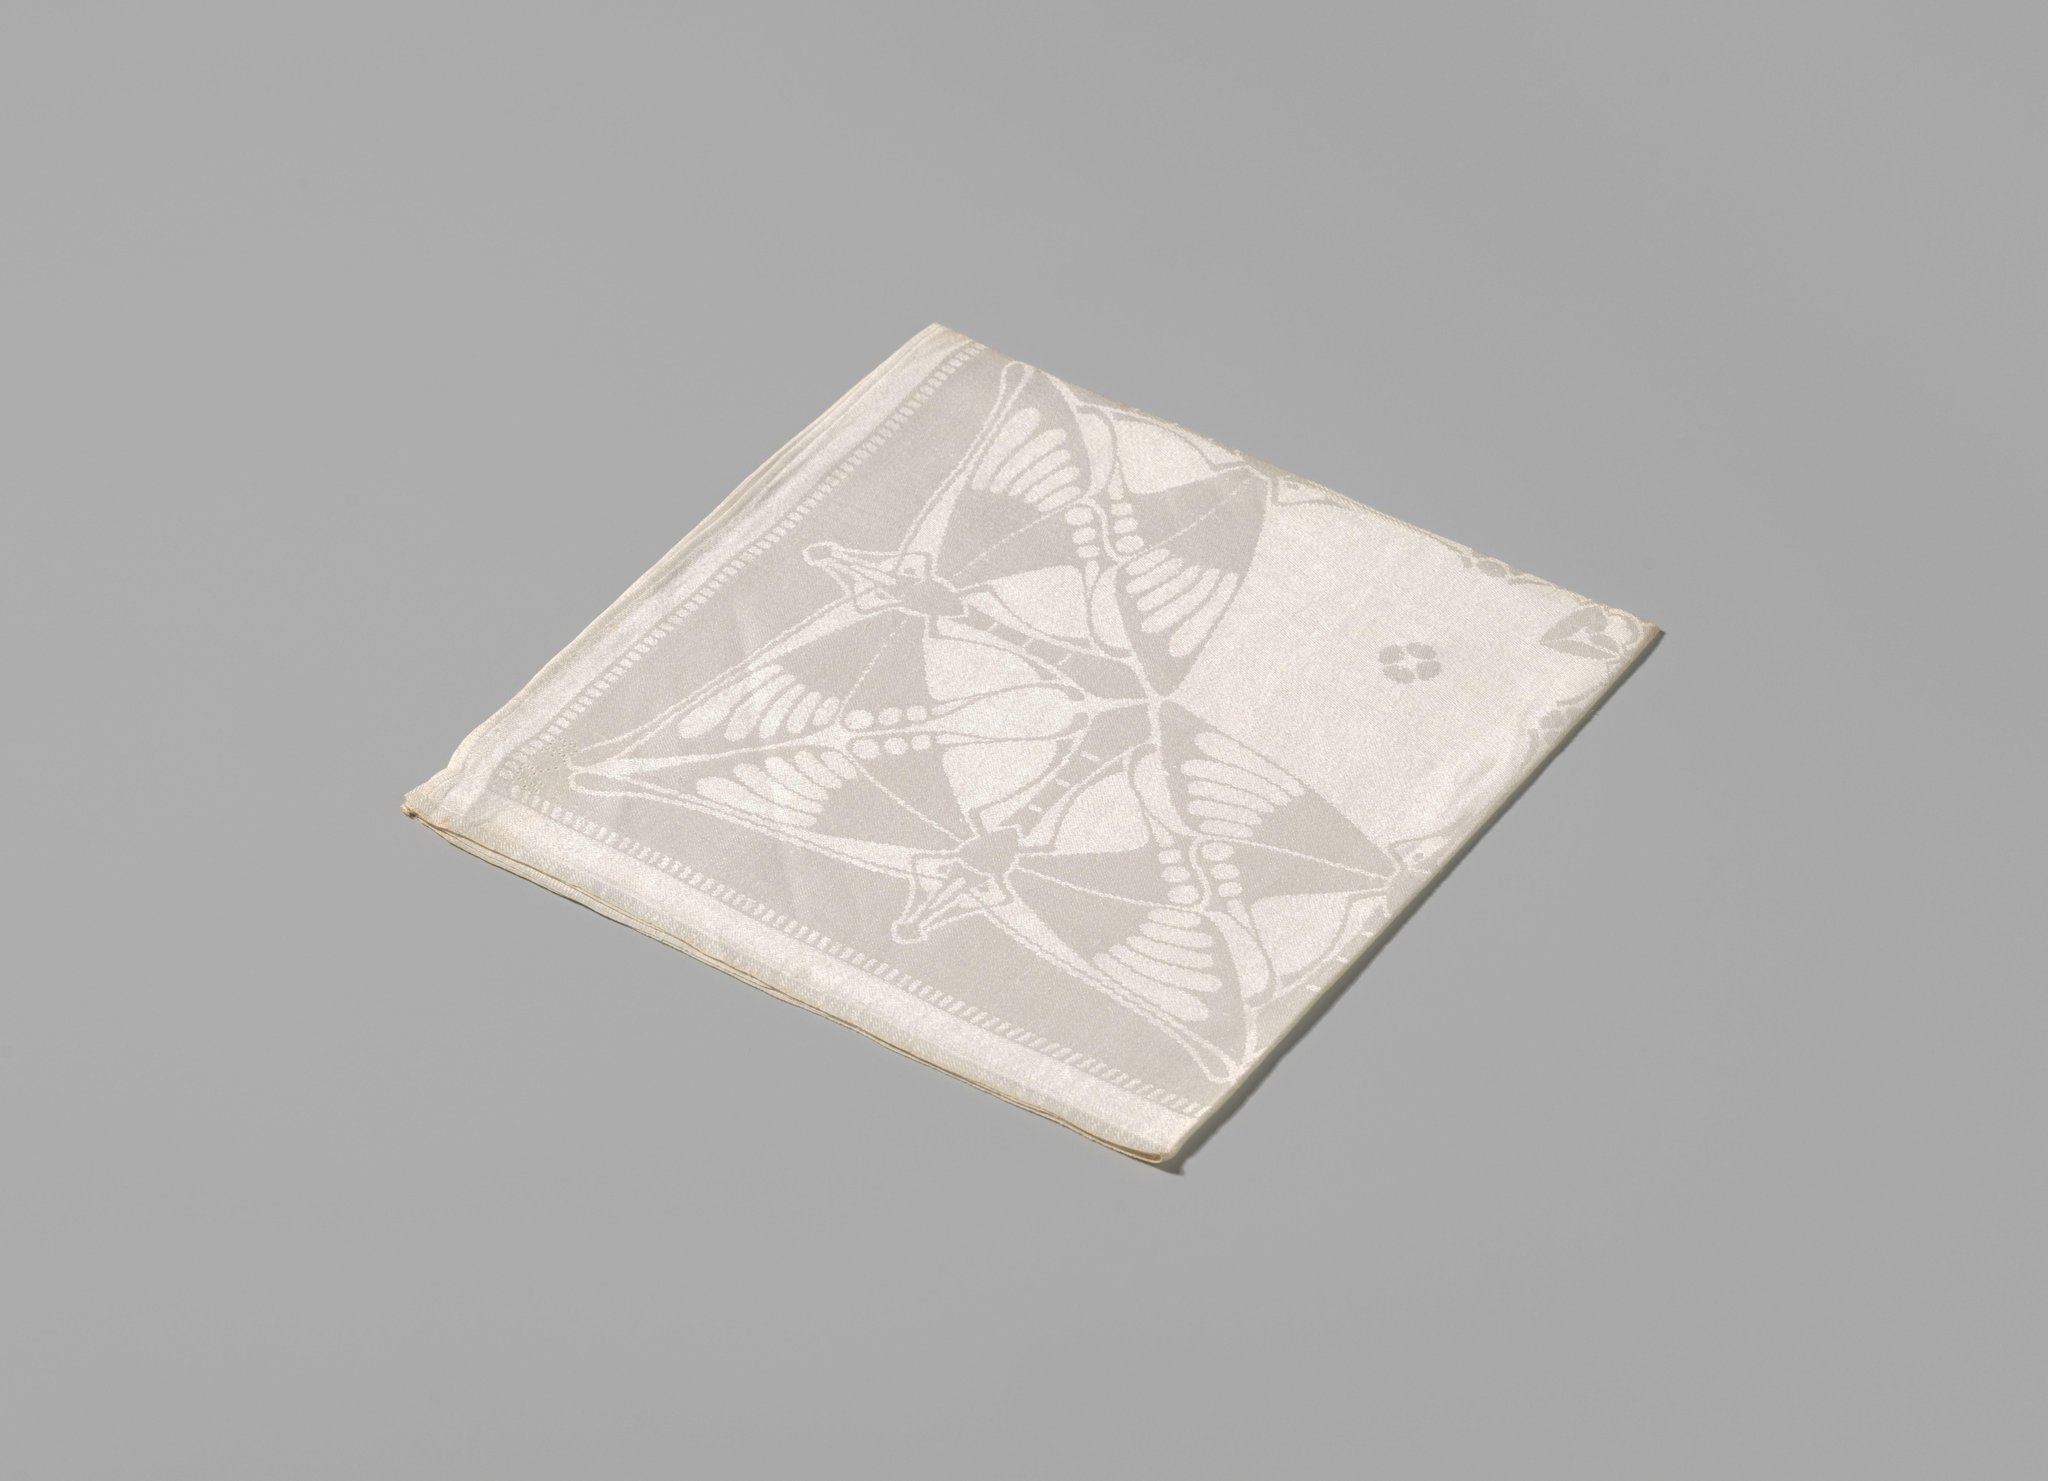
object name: vingerdoek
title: Vingerdoek van linnendamast met vlinders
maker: chris lebeau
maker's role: draughtsman, print maker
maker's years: 1878-1945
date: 1904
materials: linen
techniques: damask, weave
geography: eindhoven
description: Vingerdoek van linnendamast met vlinders: motief Vlinder, dessin nr. 505. De vingerdoek hoort bij elf vingerdoeken (BK-1979-260-A t/m BK-1979-260-L), dertien servetten (BK-1979-259-A t/m BK-1979-259-M) en twee tafellakens (BK-1979-258-A en BK-1979-258-B).